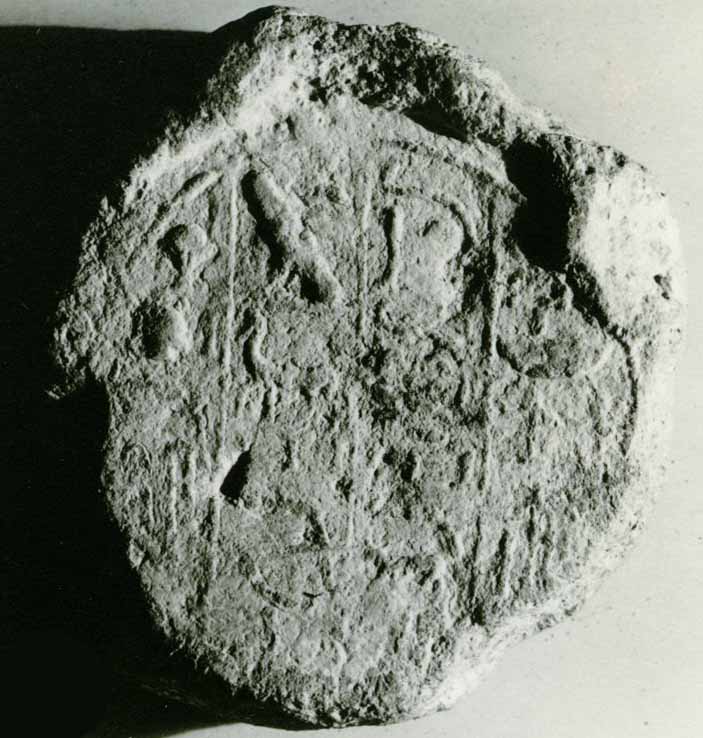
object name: cone, nebimose, circular impression, horse, livestock, cattle, overseer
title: Funerary Cone of Overseer of Cattle Nebimose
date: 1550-1295 BCE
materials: pottery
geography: egypt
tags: hieroglyphs